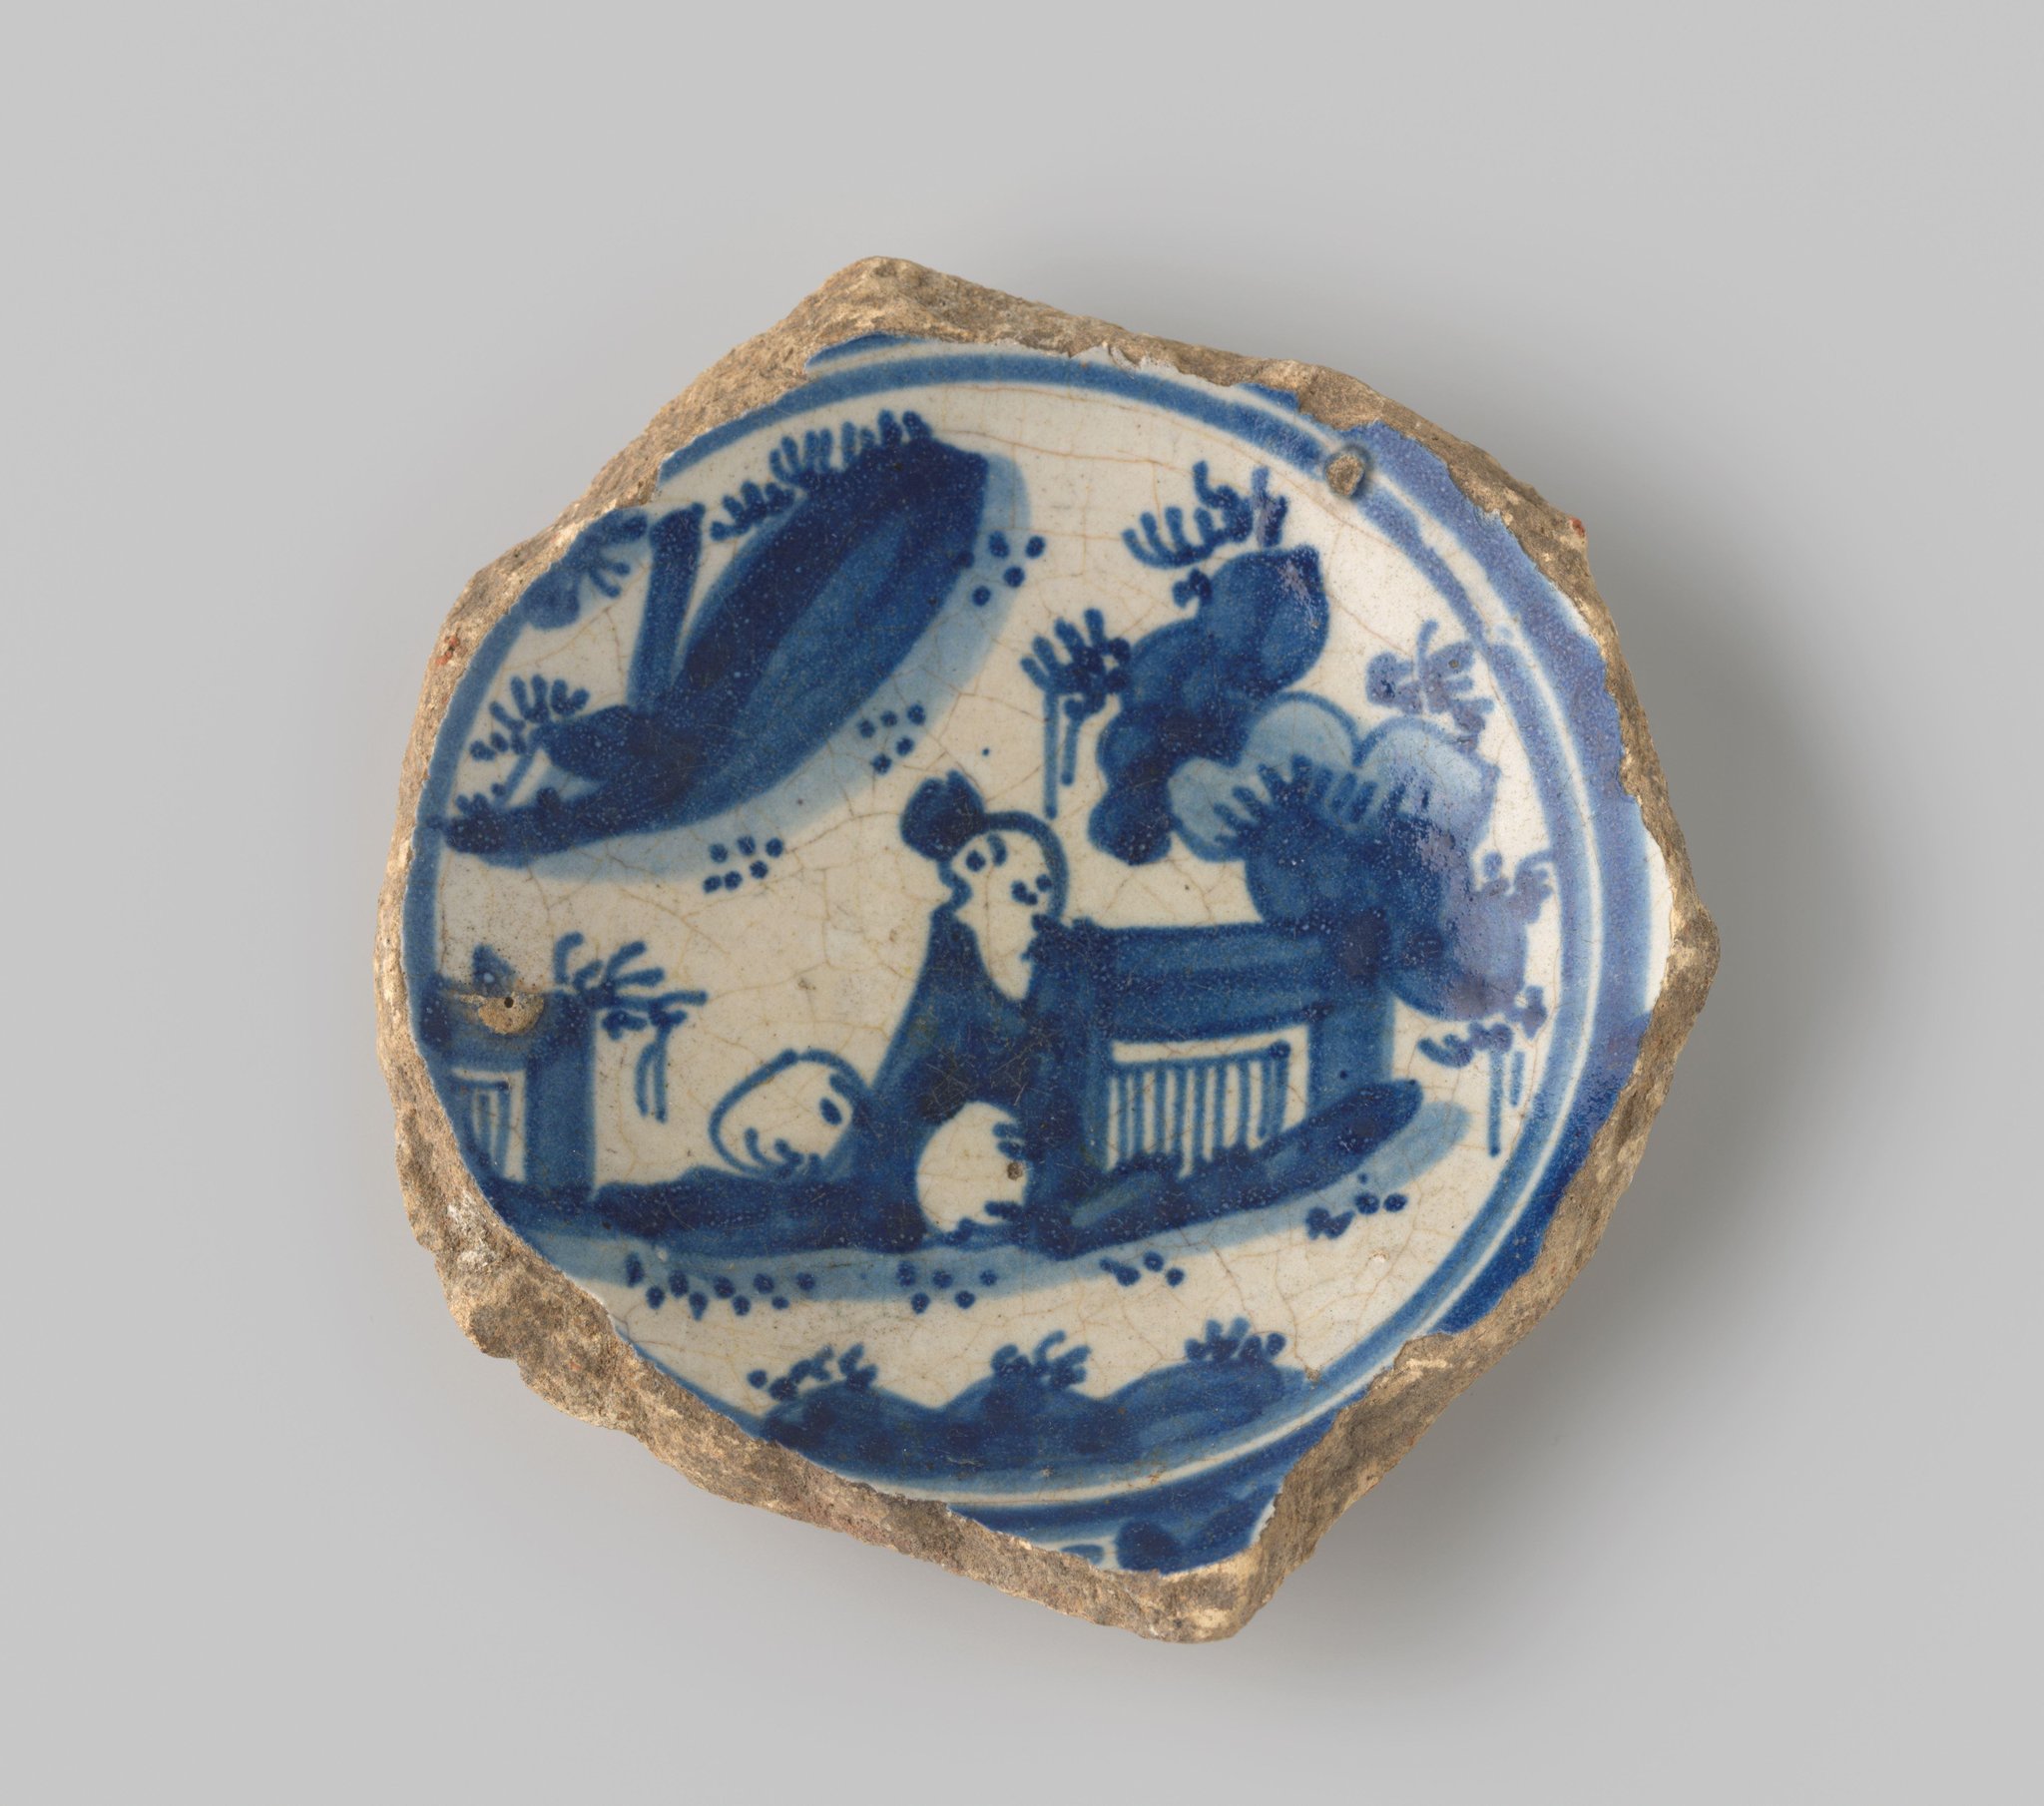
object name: platter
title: Fragment van een schotel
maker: Anonymous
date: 1600-1625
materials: earthenware, glaze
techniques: maiolica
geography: northern netherlands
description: Fragment van een schotel op een lage voetring. Crème scherf bedekt met tinglazuur aan de voorzijde en groene loodglazuur aan de achterzijde. Beschilderd in blauw met een Chinees zittend bij een hek in een tuin binnen cirkels.